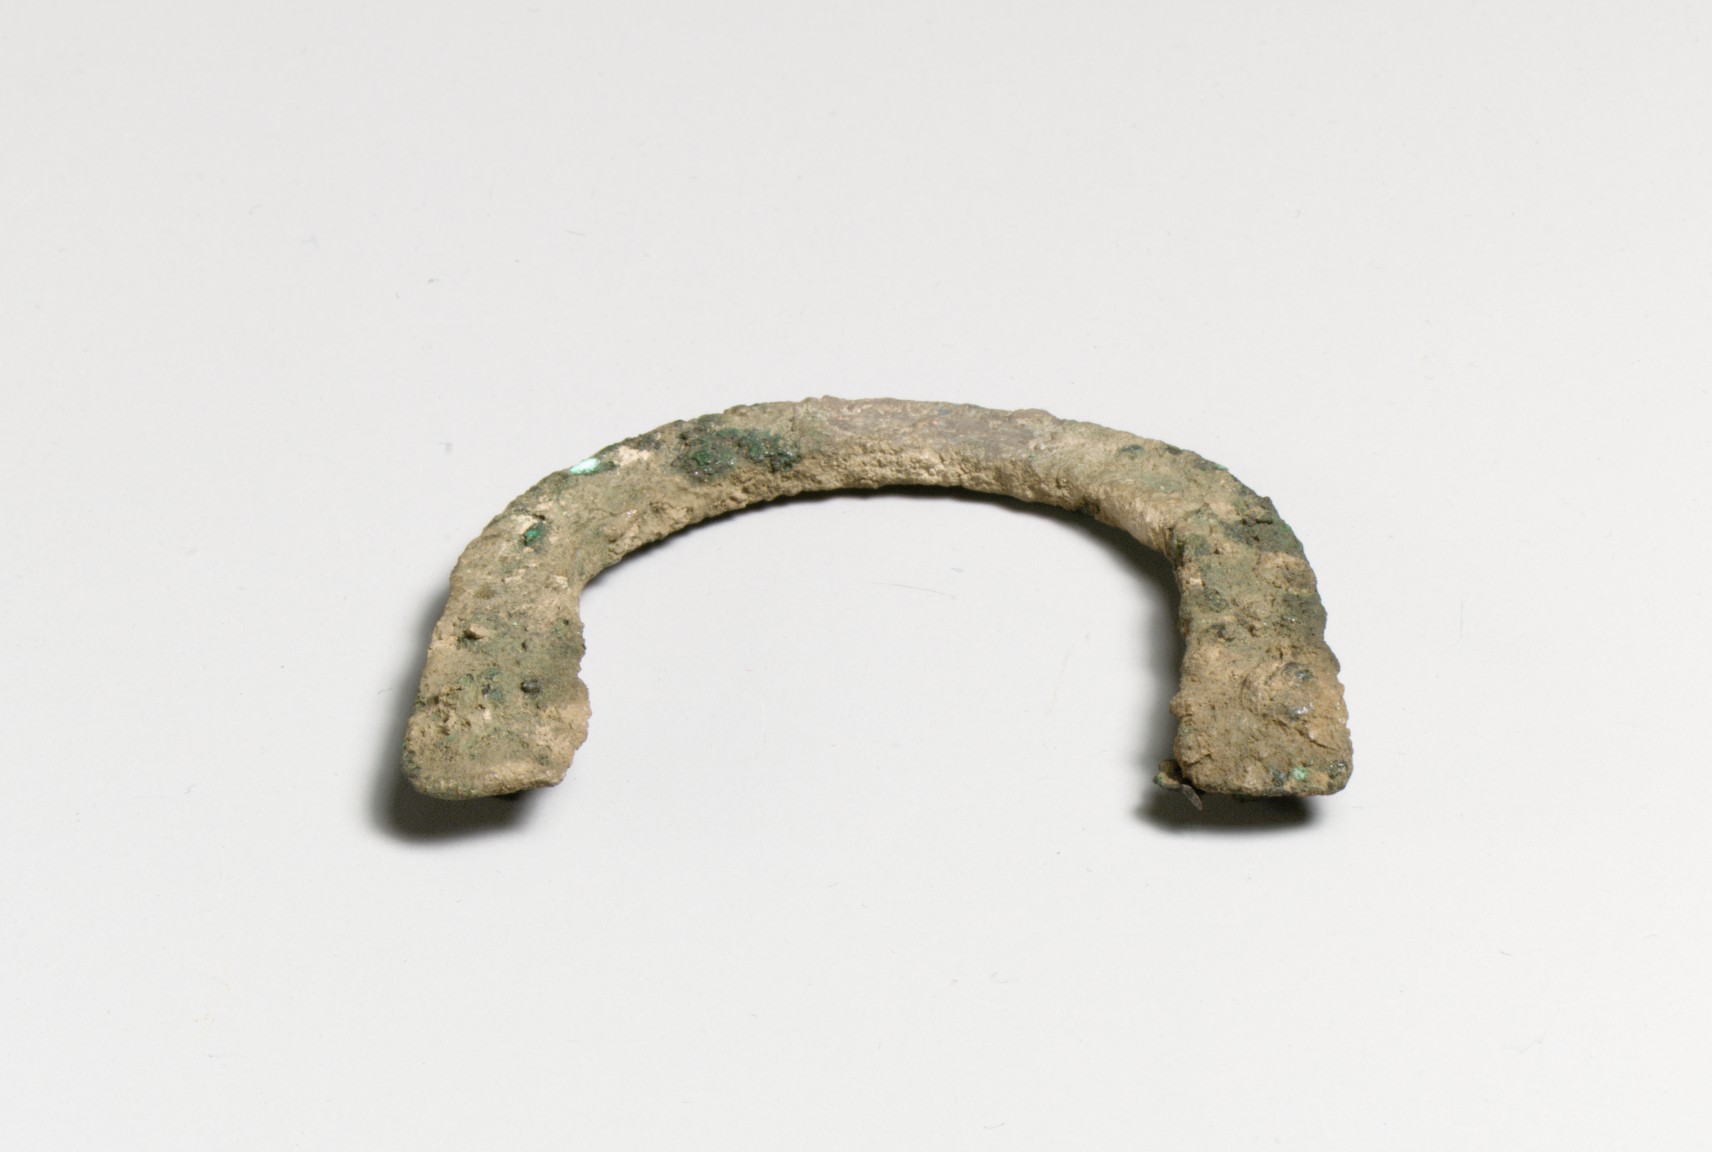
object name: handle of a bowl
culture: cypriot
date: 3900 BCE-100 CE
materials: bronze